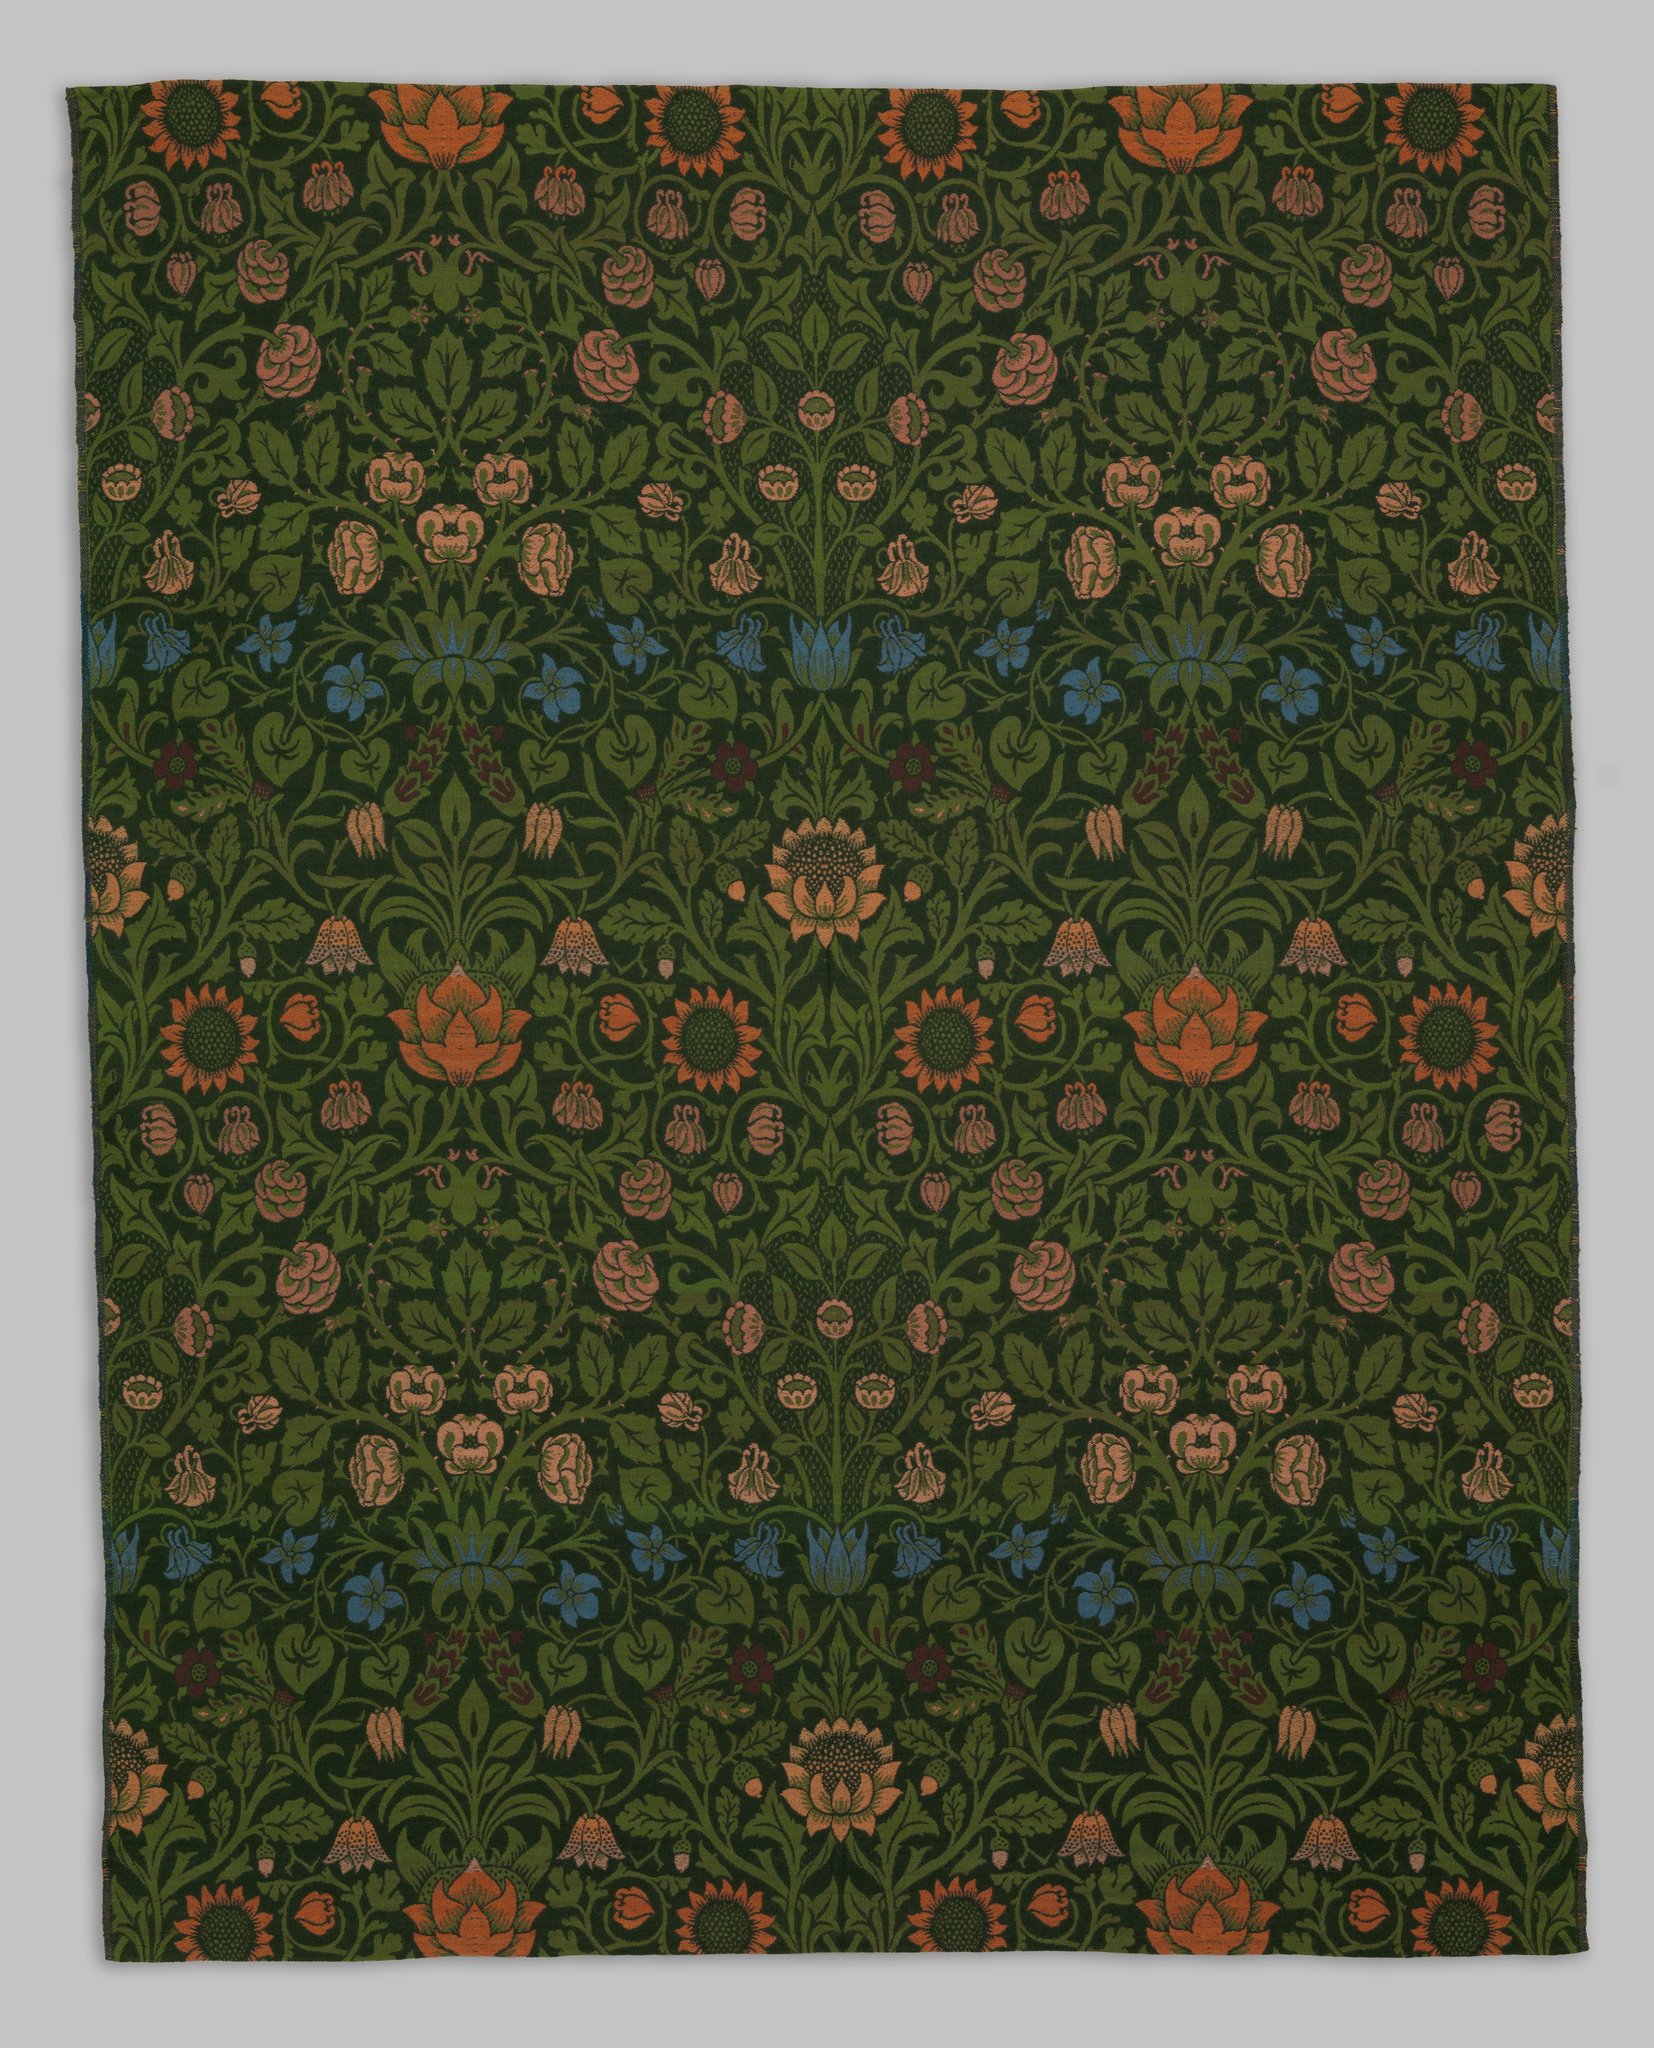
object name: sample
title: Violet and Columbine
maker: william morris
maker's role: designer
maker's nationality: british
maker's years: 1834-1896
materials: wool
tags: violets